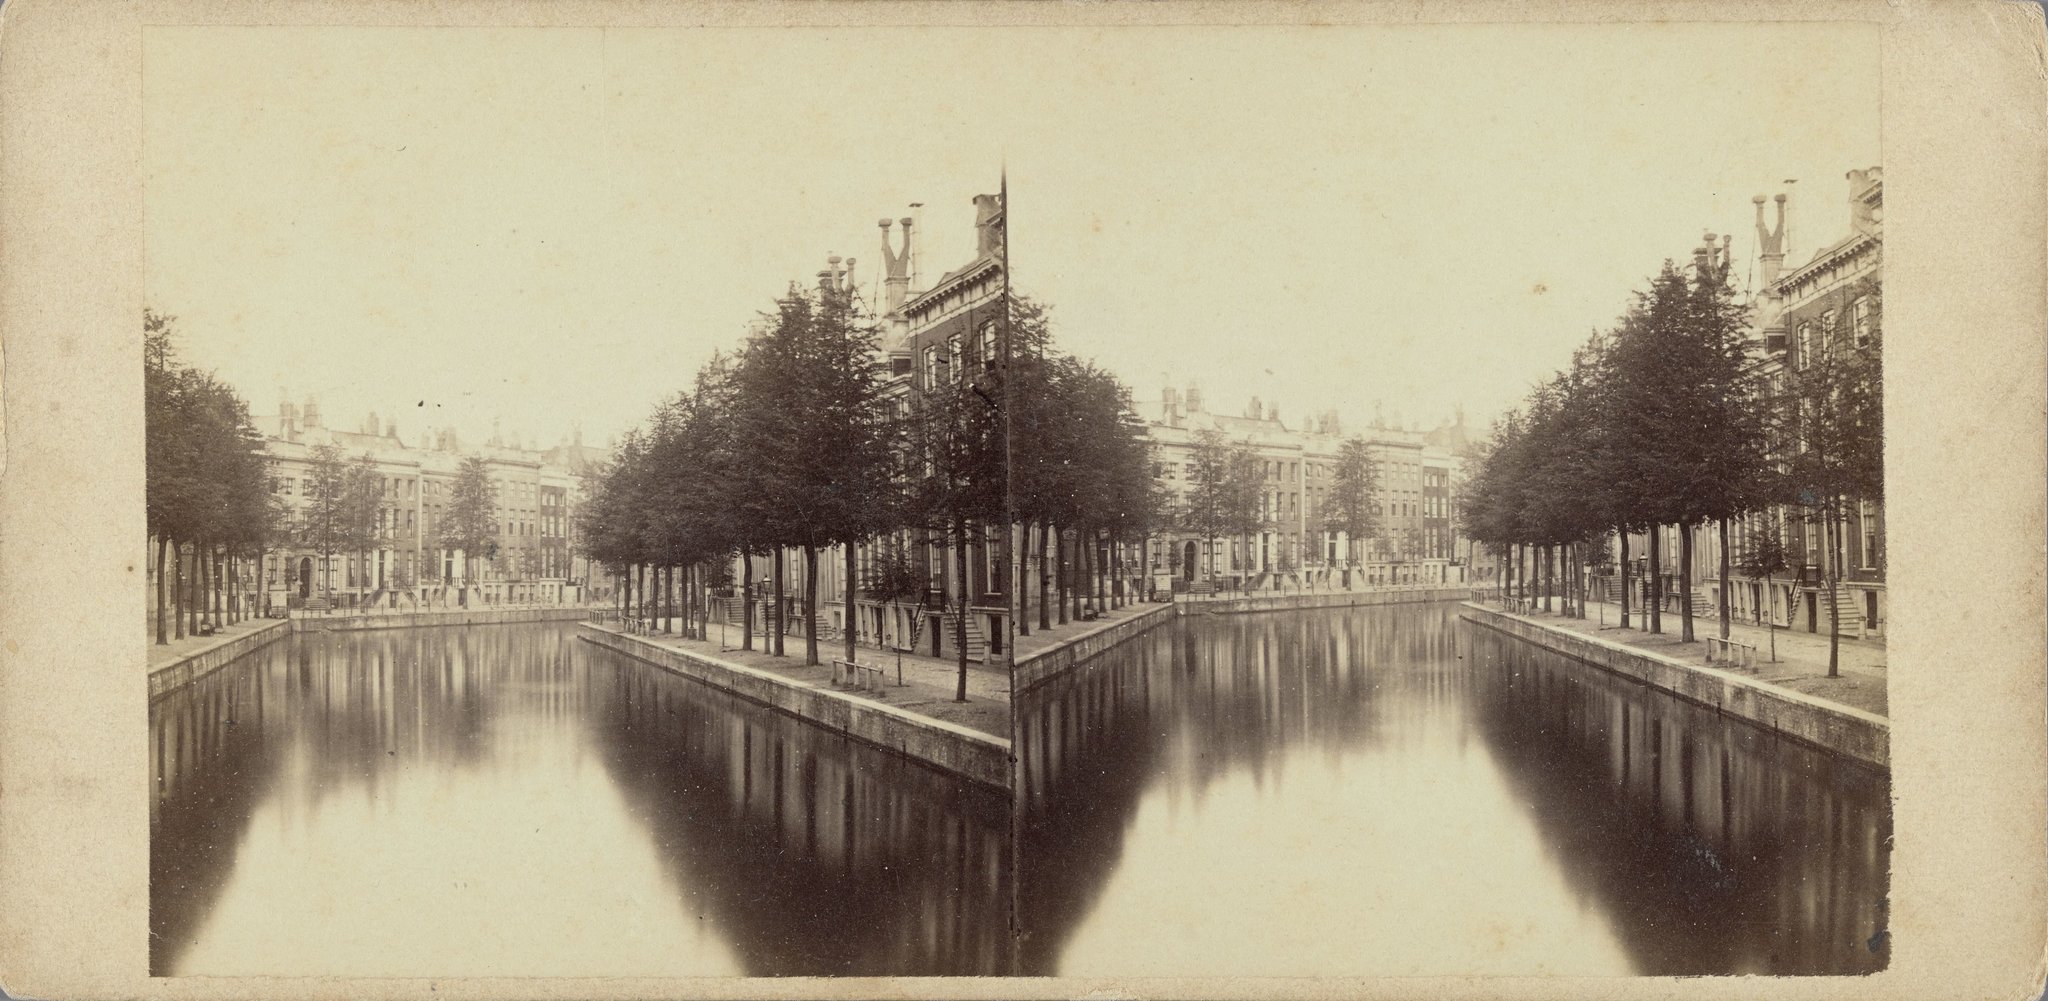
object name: stereograph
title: Gezicht op de bocht in Herengracht te Amsterdam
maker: Anonymous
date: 1860-1870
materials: cardboard, paper, photographic support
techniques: albumen print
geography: amsterdam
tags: canal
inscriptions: inscription: ‘Vues de Hollande. Amsterdam. Bogt Heerengracht. No. 204’